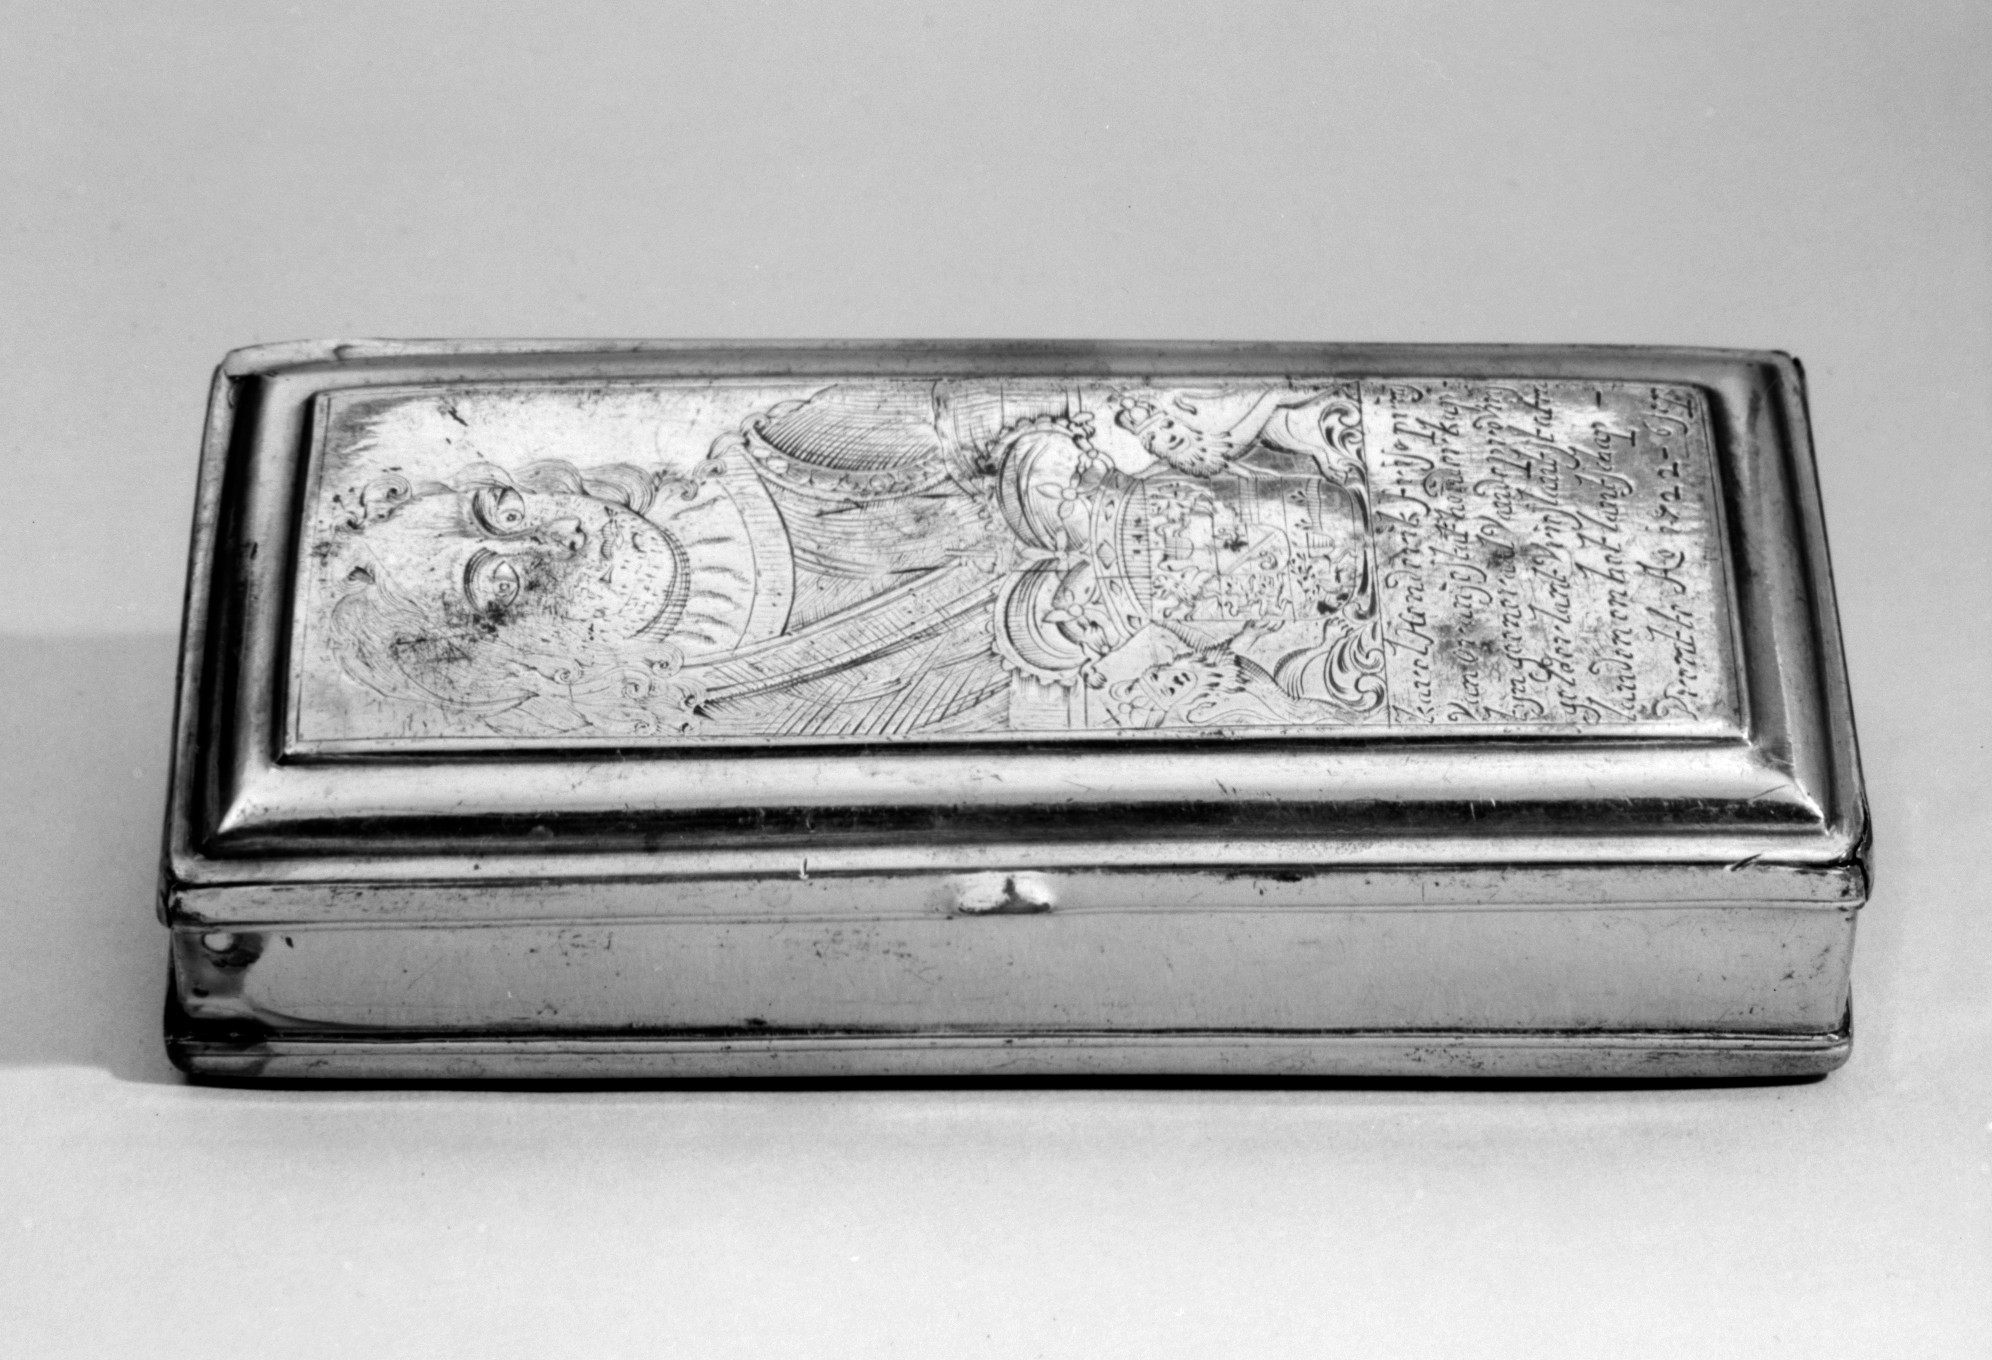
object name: tobacco box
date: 1734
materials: copper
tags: men,women,coat of arms